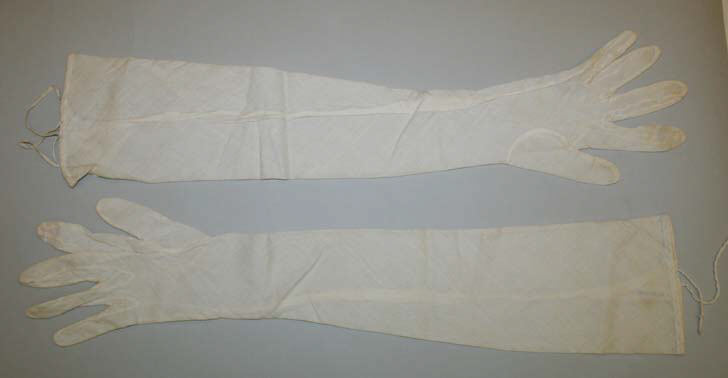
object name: glove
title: Gloves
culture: american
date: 1800-1825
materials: cotton